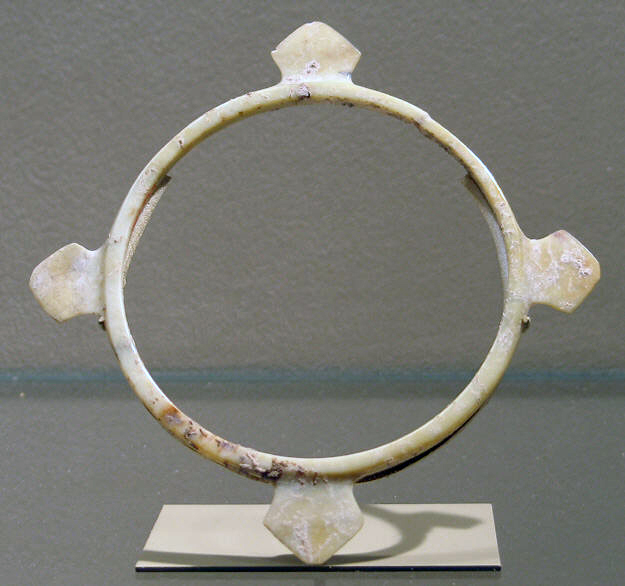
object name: bangle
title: Bangle with Flanges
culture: thai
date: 500 BCE-300 CE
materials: stone